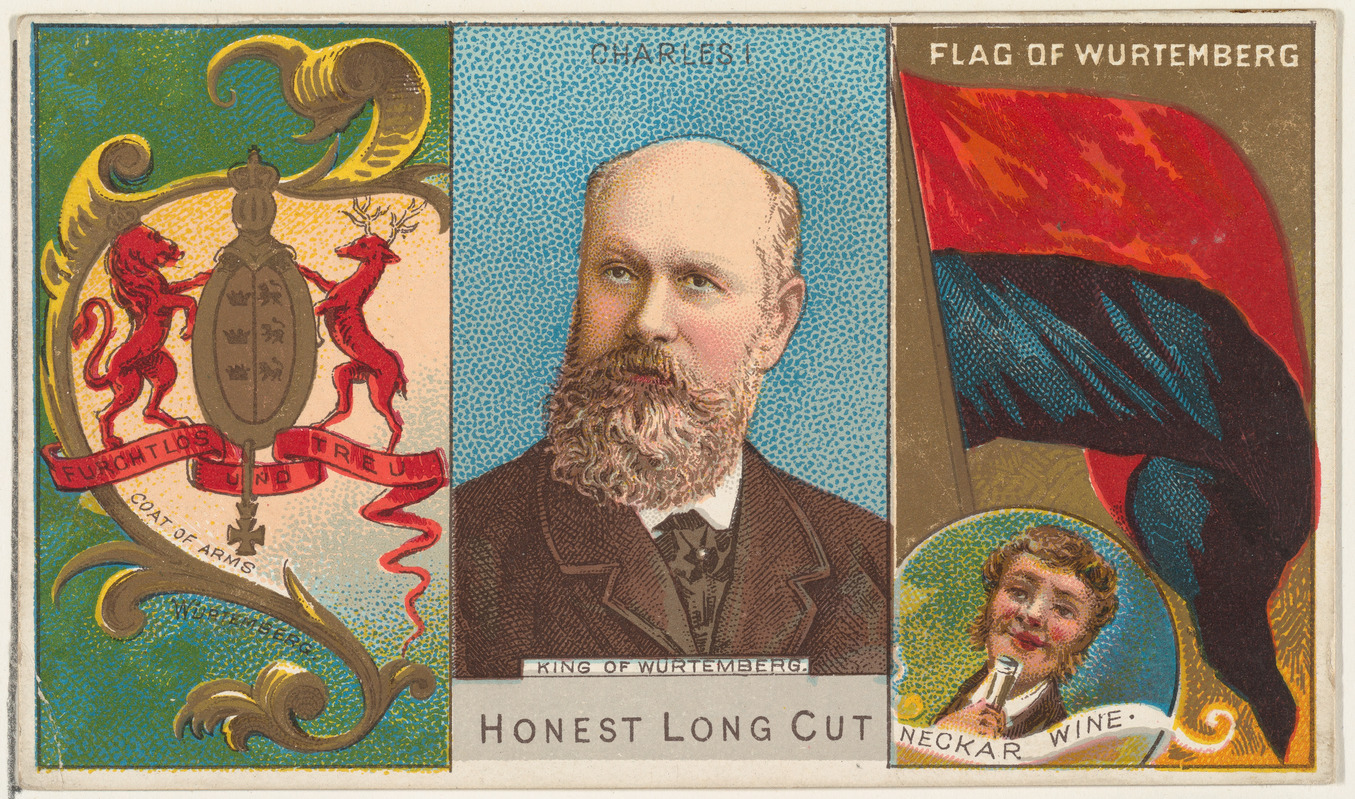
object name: print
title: Charles I, King of Wurtemberg, from the Rulers, Flags, and Coats of Arms series (N126-1) issued by W. Duke, Sons & Co.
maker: w. duke, sons & co.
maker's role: publisher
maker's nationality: american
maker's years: 1870-1920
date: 1888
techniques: color lithograph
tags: men,portraits,coat of arms,flags